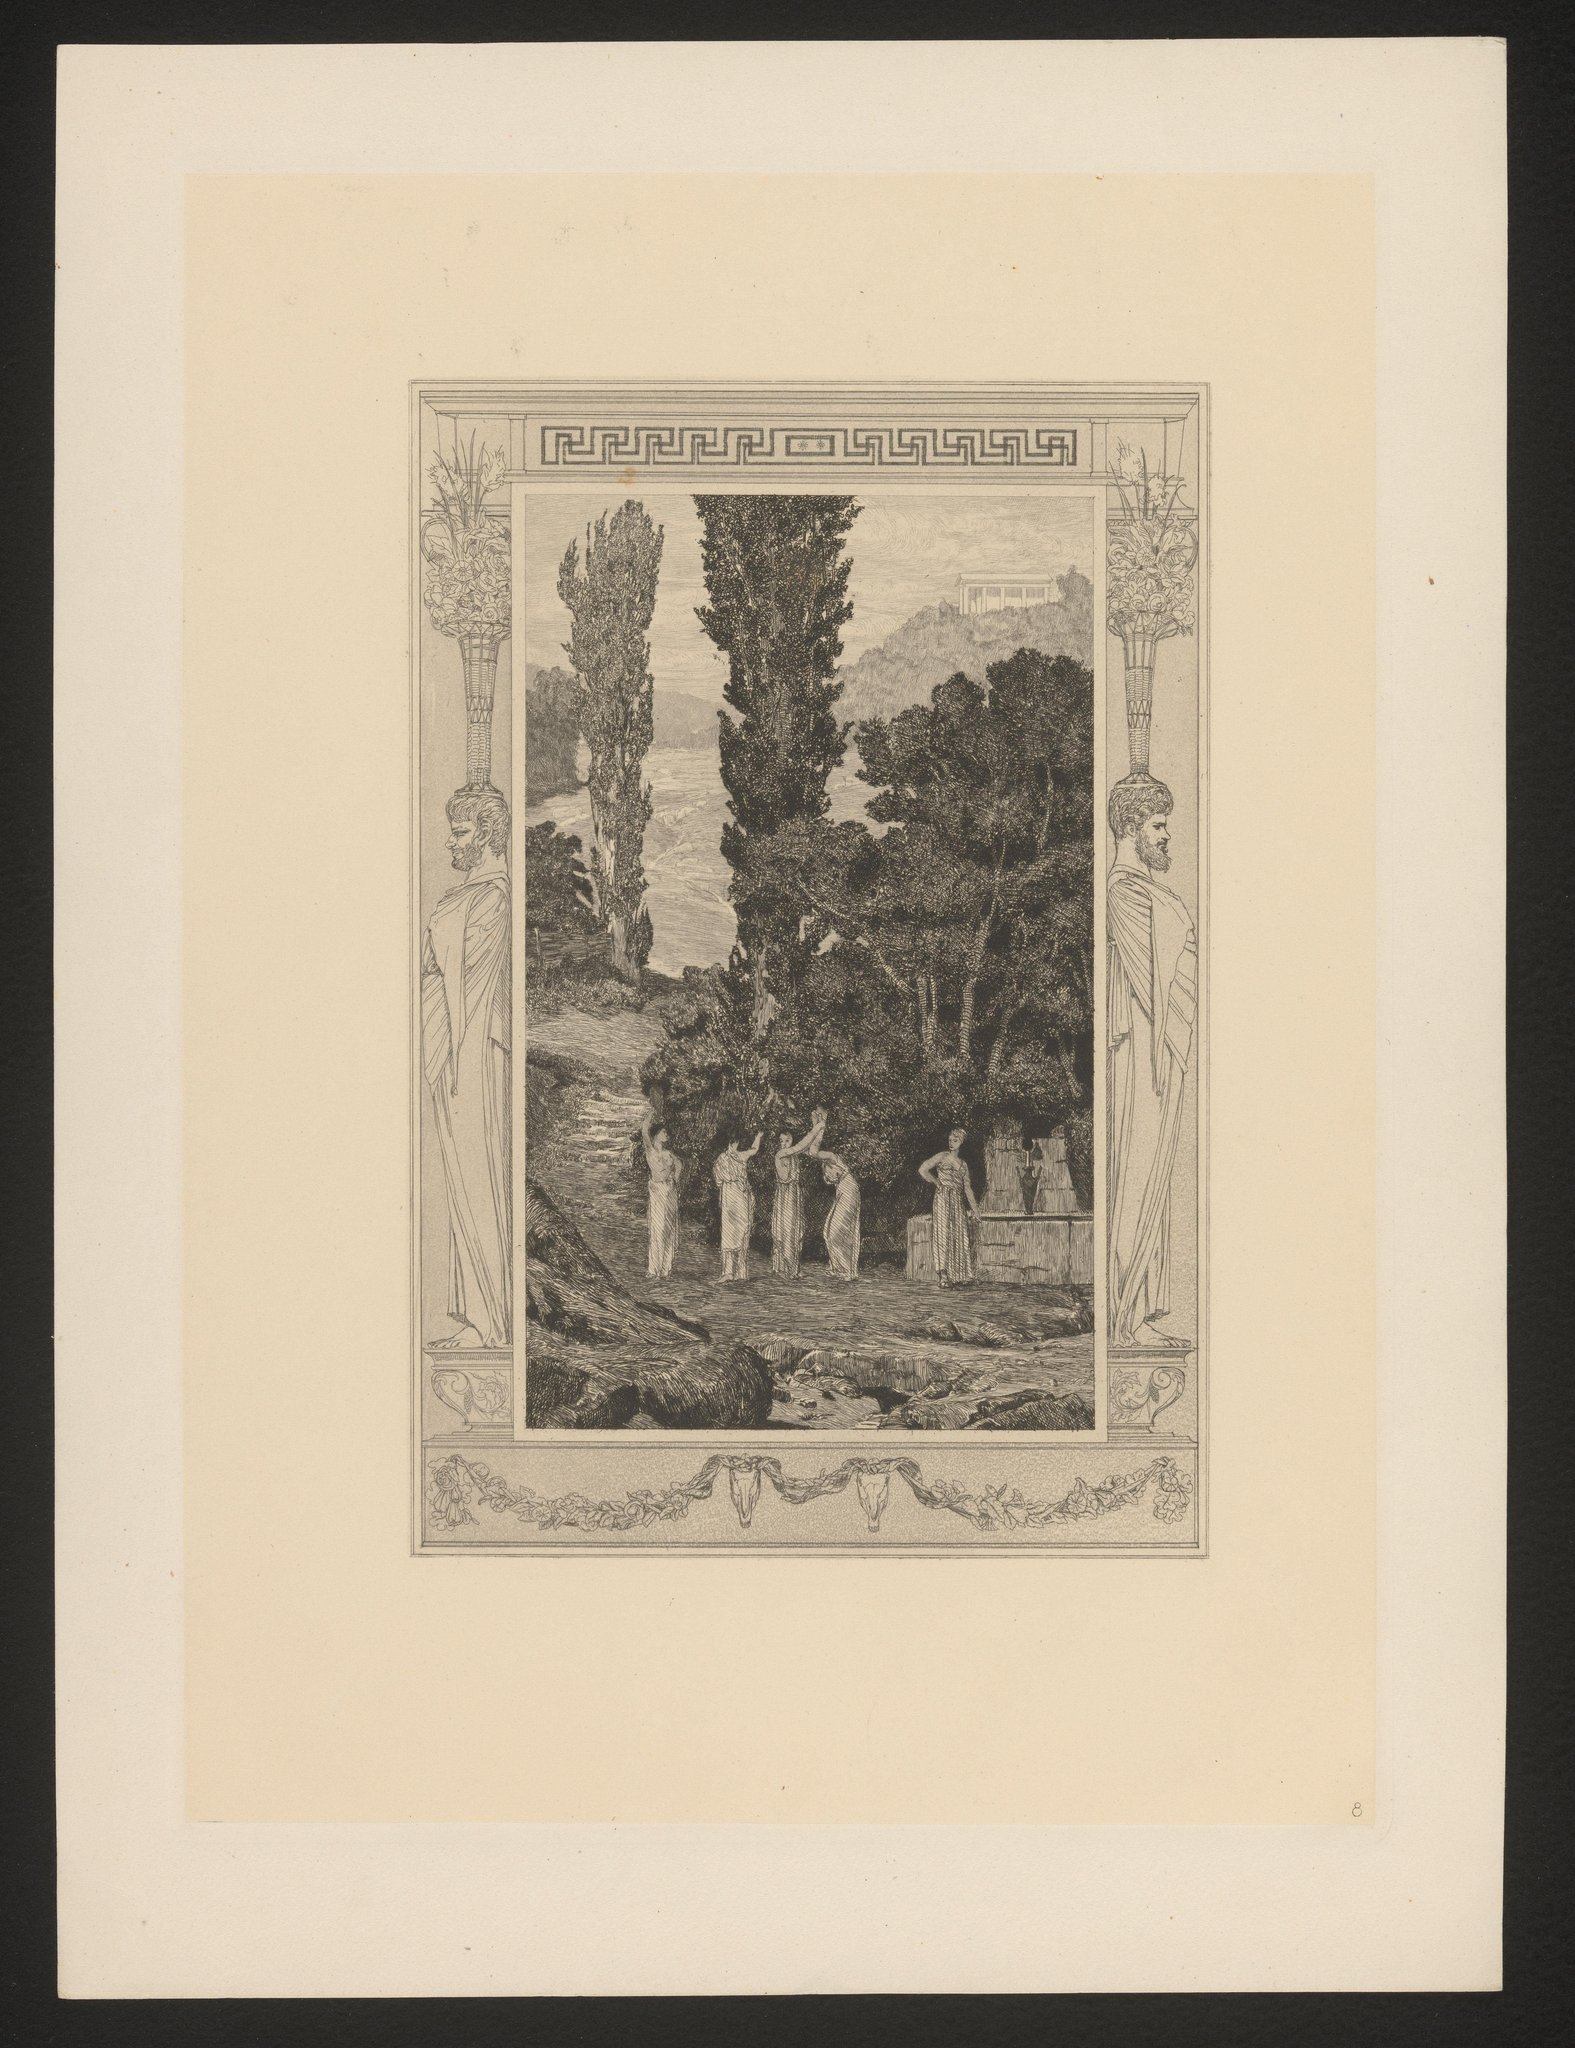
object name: print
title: Radierungen zu Apulejus' Märchen Amor und Psyche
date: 1880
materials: paper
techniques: aquatint, etching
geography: nuremberg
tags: story of cupid and psyche (apuleius, 'metamorphoses' (golden ass) iv 28 - vi 25)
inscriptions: collector's mark: Lugt 2228